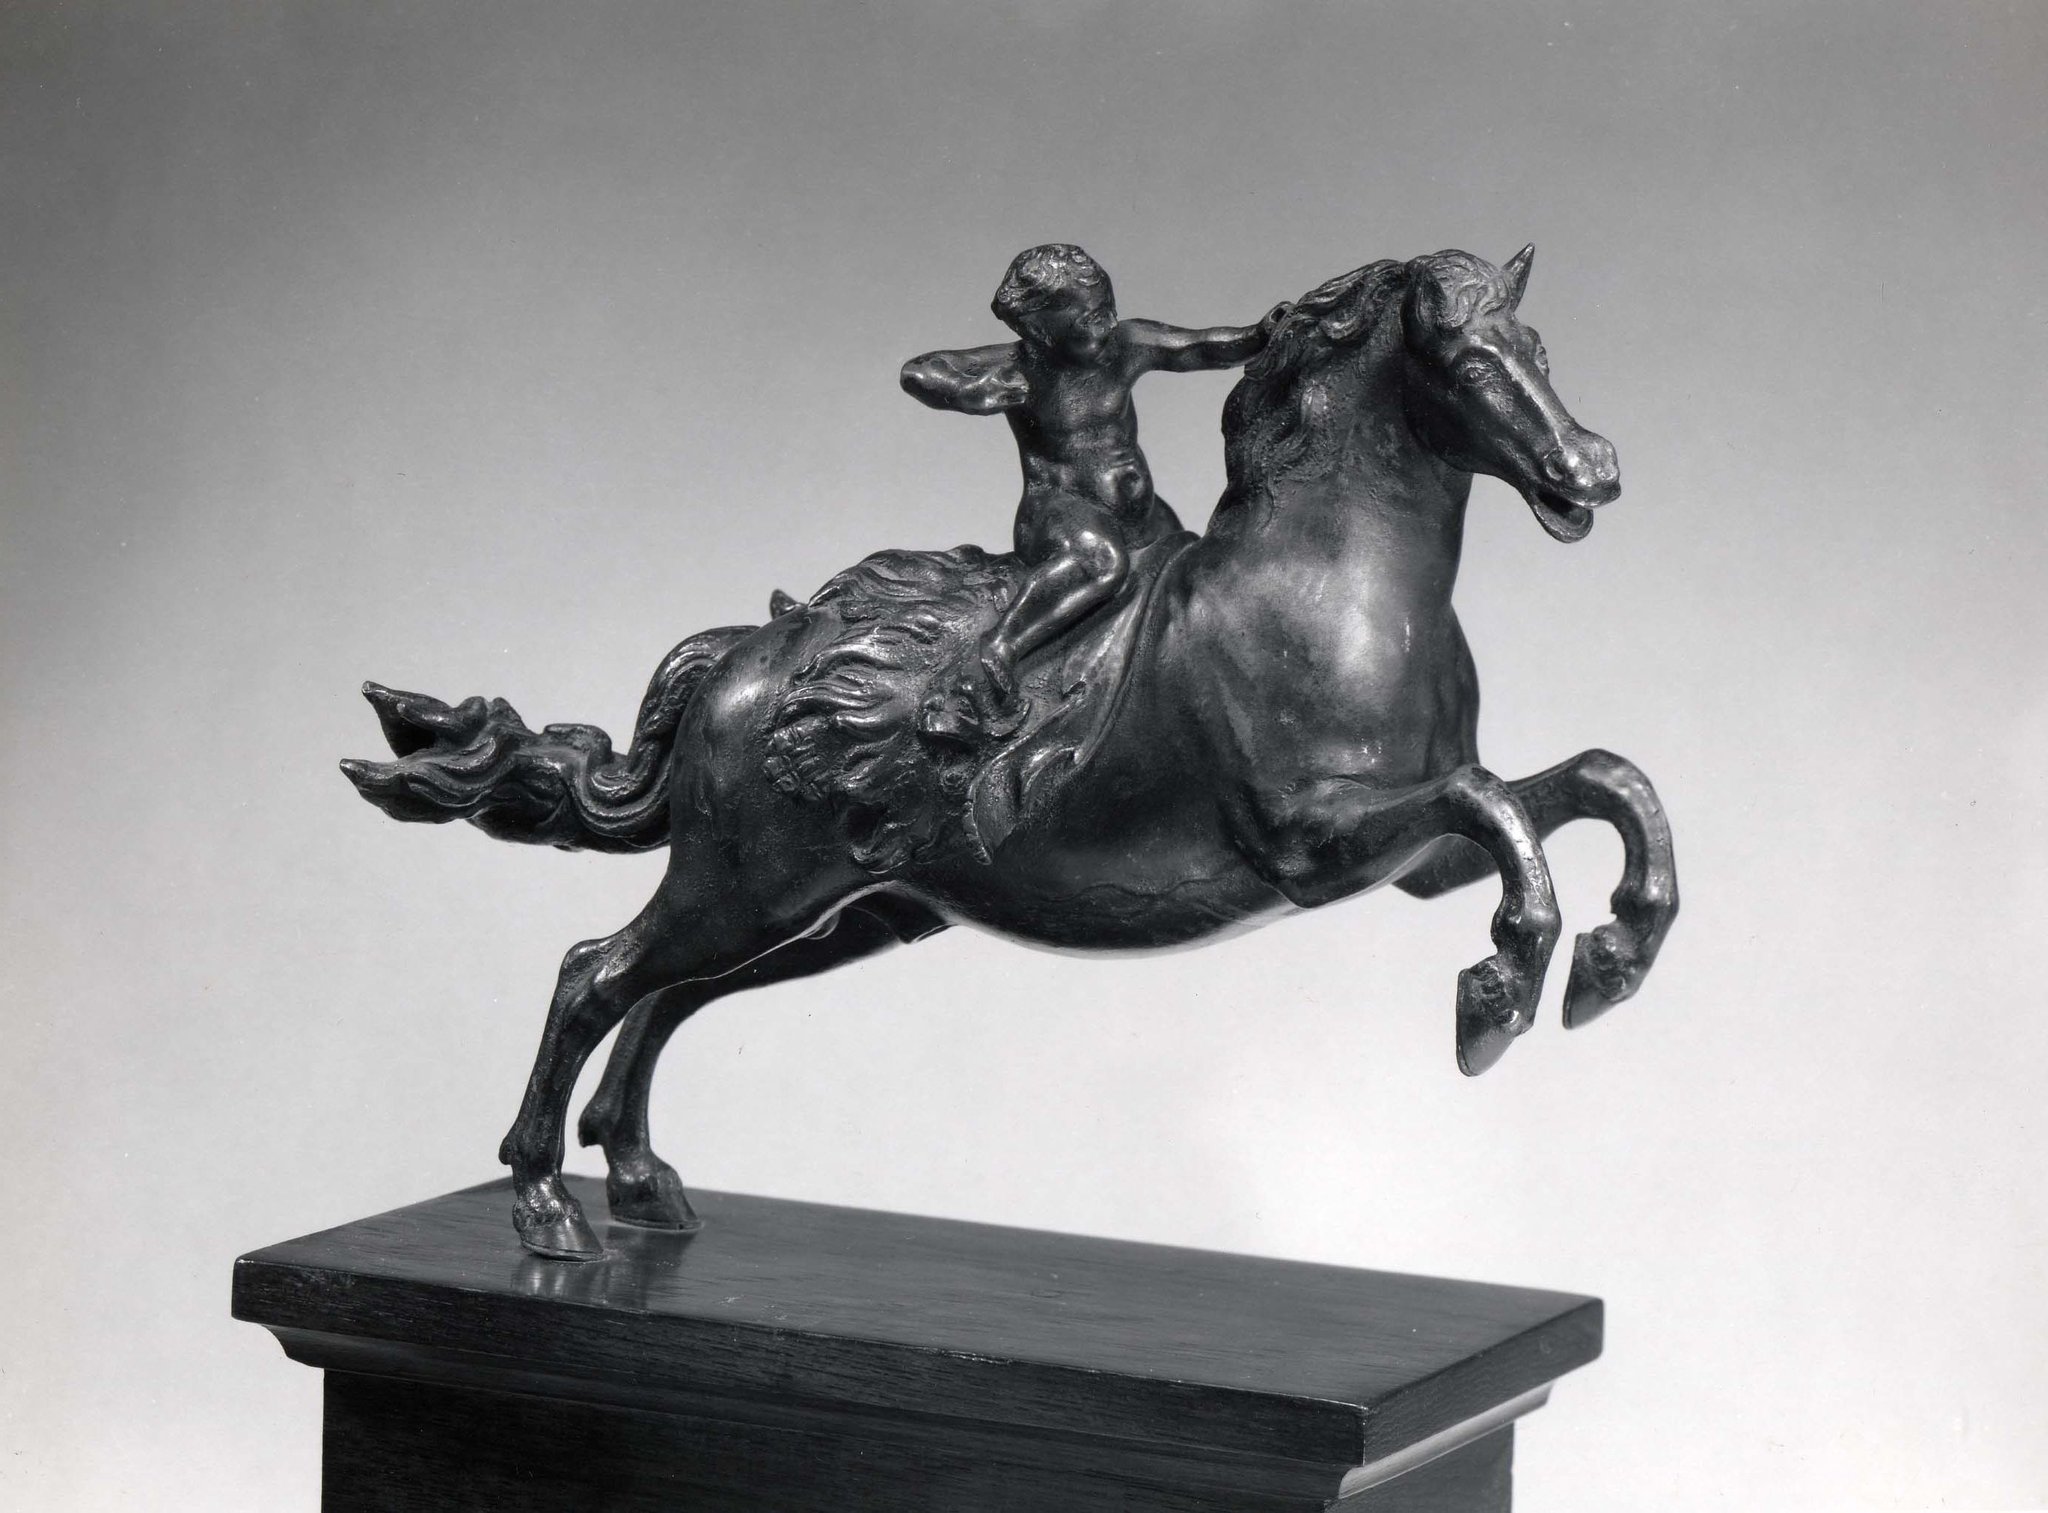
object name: sculpture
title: Cupid on Horseback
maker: francesco fanelli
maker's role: artist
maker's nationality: italian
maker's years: 1608-1665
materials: copper alloy, lacquer, patina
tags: cupid,horses